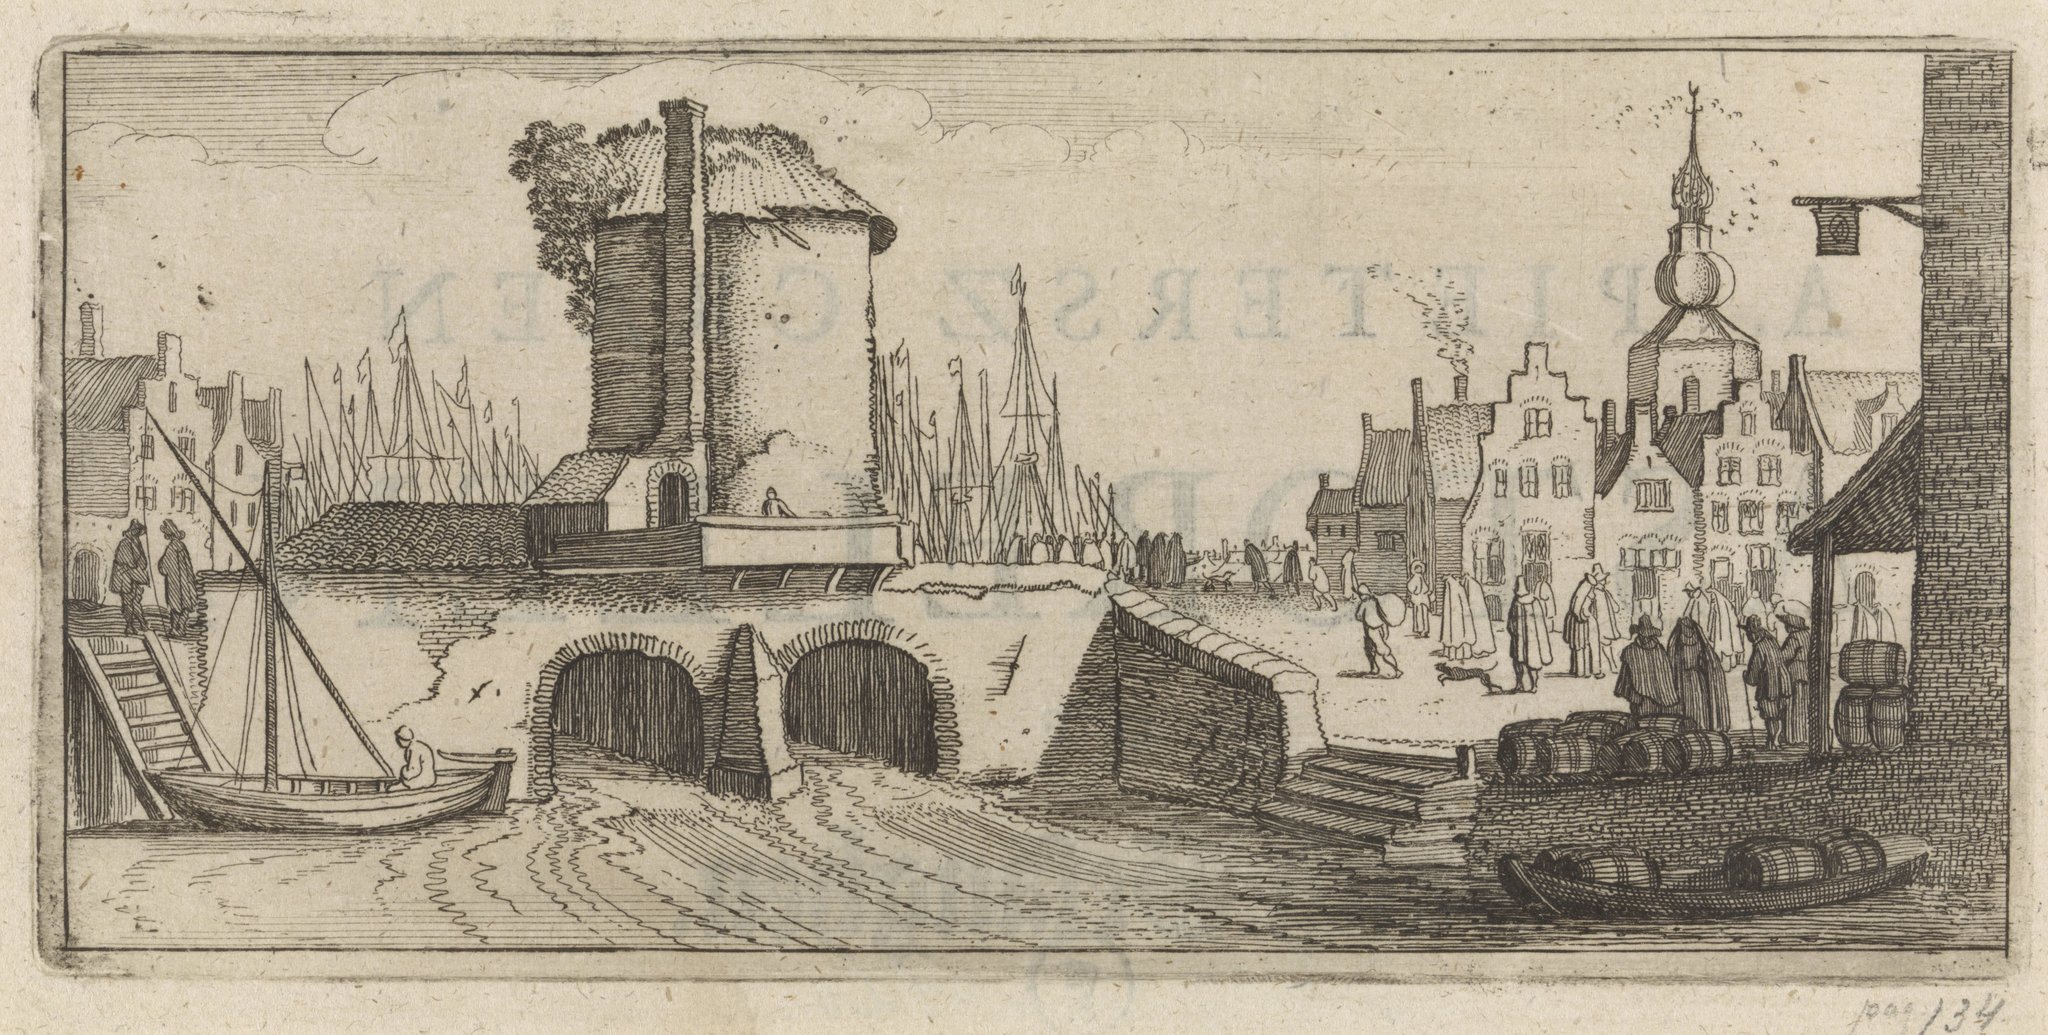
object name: book illustration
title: Gezicht op een brug in een stad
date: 1627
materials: paper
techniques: etching, letterpress printing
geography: amsterdam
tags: square, place, circus, etc., bridge in city with structures, i.e. shops, houses, e.g. ponte vecchio in florence (+ city(-scape) with figures, staffage), city-view in general; 'veduta', parts of church exterior and annexes: tower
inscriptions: collector's mark: Lugt 964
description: Boekillustratie in: Campanus, M., Colevelt, J.J. Craen, A.P., Robbertzen, J. Amsterdamsche Pegasus, waer in (uyt lust) byeen vergadert zijn veel minnelycke liedekens. Amsterdam: Cornelis Willemsz Blaeu-laken, 1627.